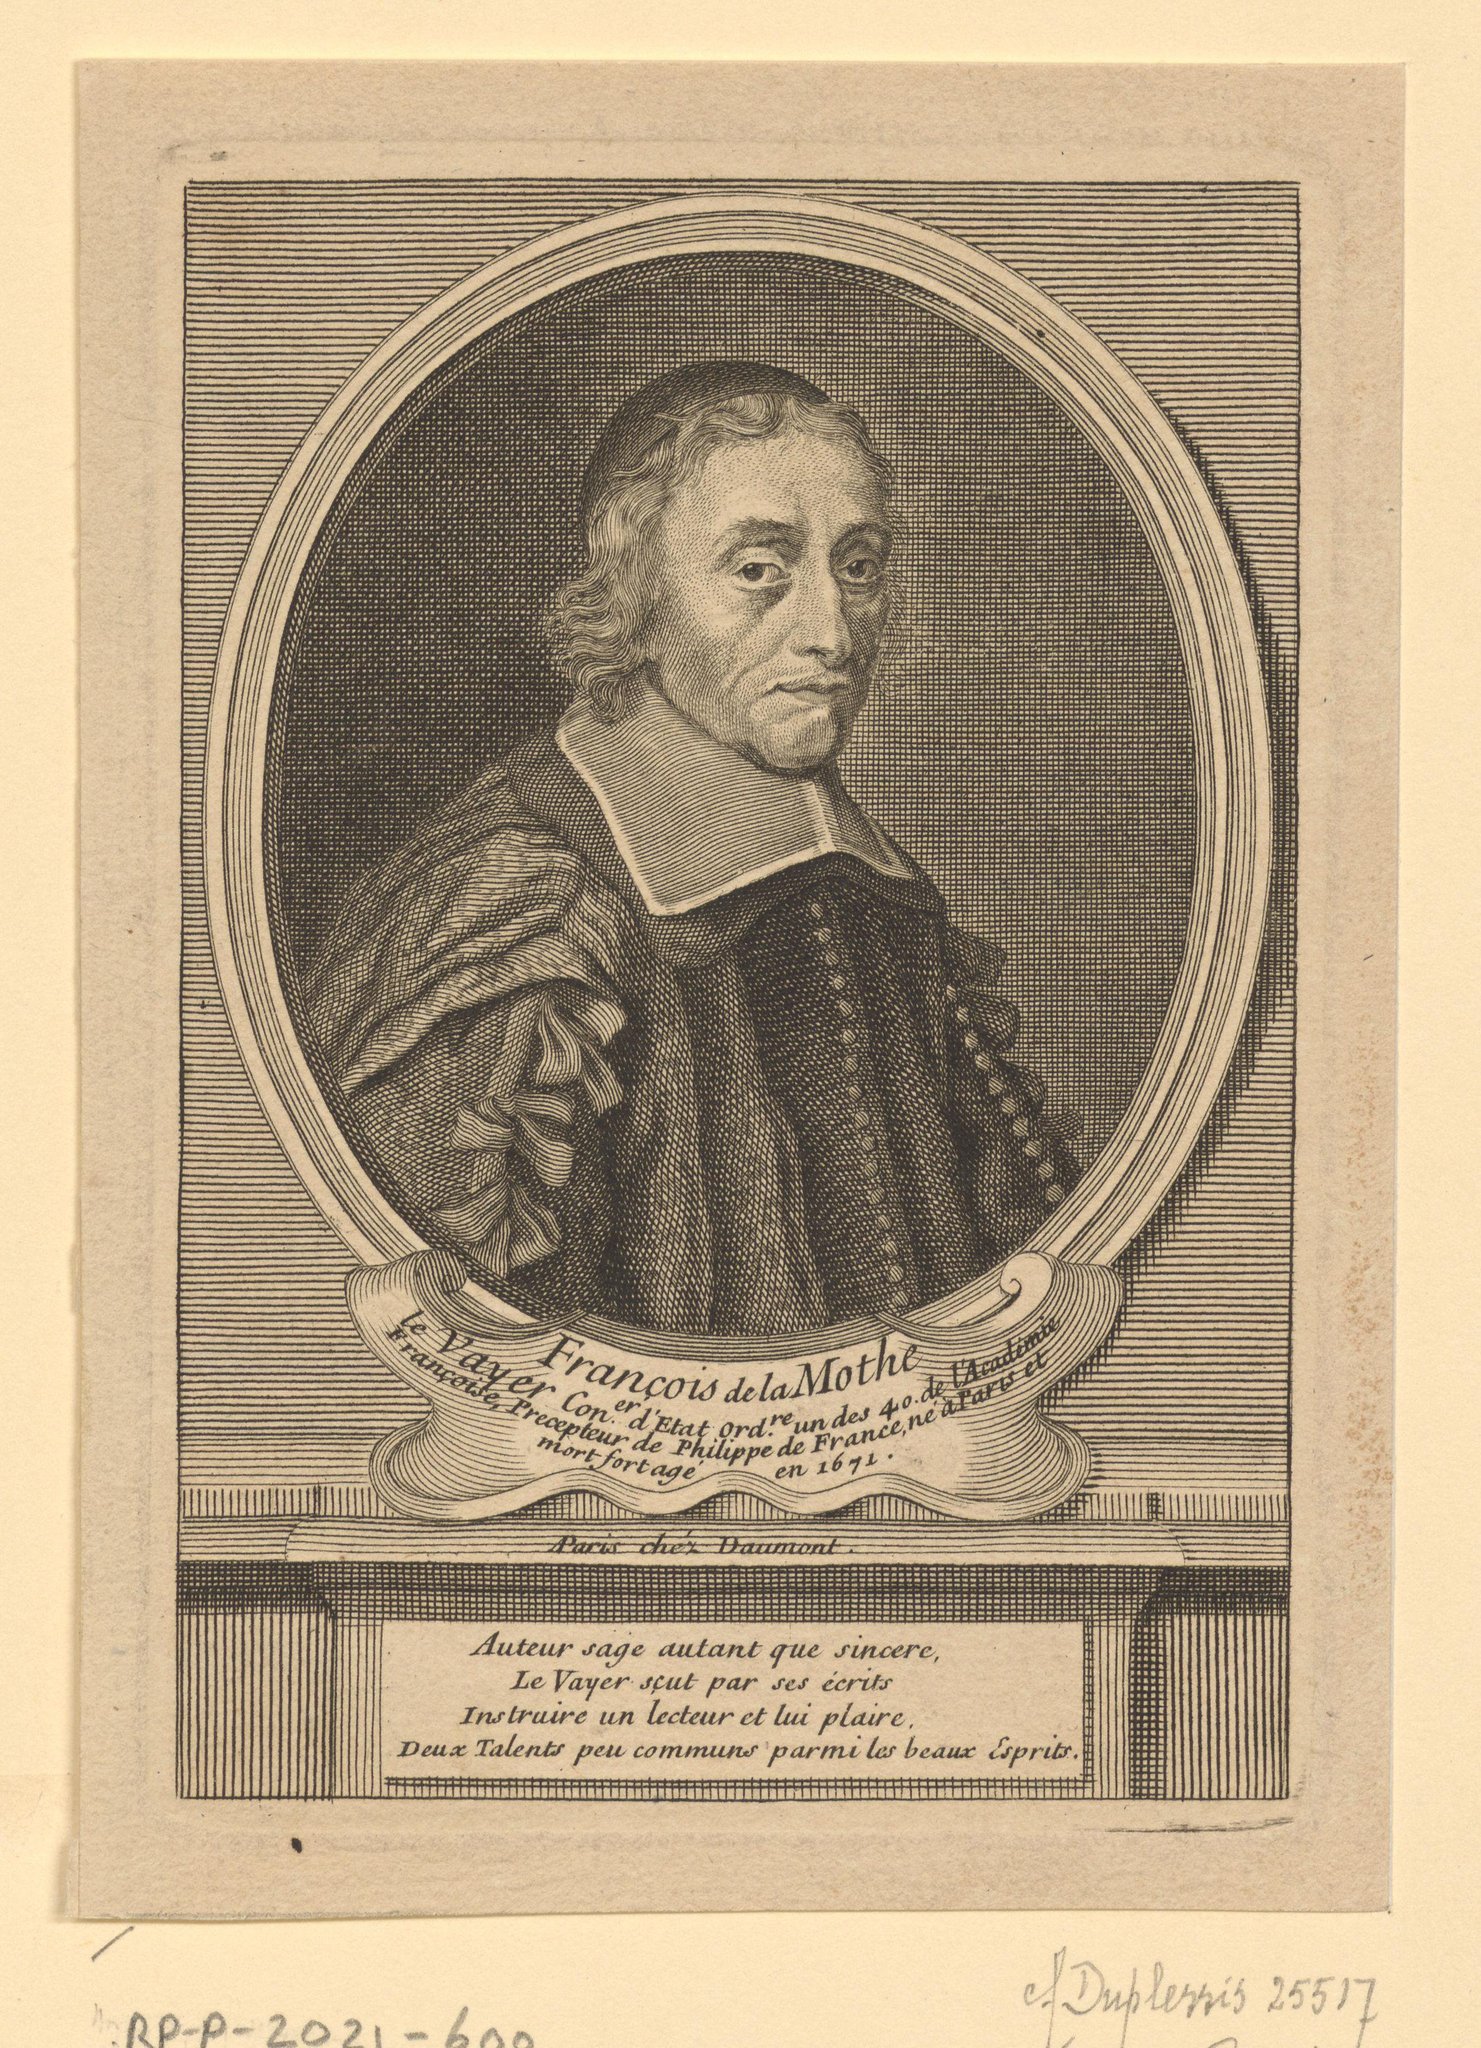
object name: print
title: Portret van François de La Mothe Le Vayer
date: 1745-1775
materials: paper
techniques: engraving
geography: paris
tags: paris, ornament ~ medallion, historical persons, portrait of a writer, ornament ~ cartouche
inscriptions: collector's mark: Lugt 2228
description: Met vierregelig vers in het Frans onder het portret.